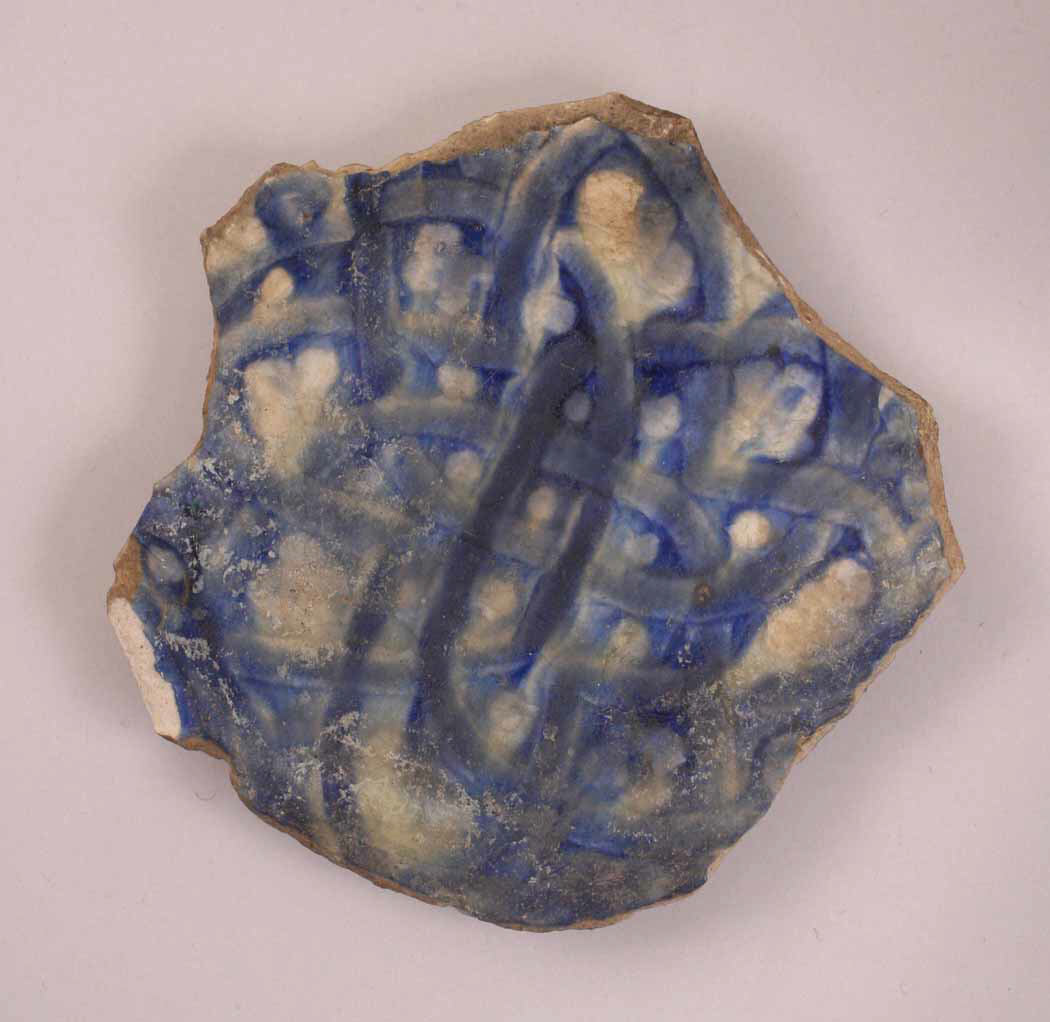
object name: fragment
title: Ceramic Fragment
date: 1301-1500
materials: glaze, stonepaste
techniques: painting, underglaze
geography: egypt or syria